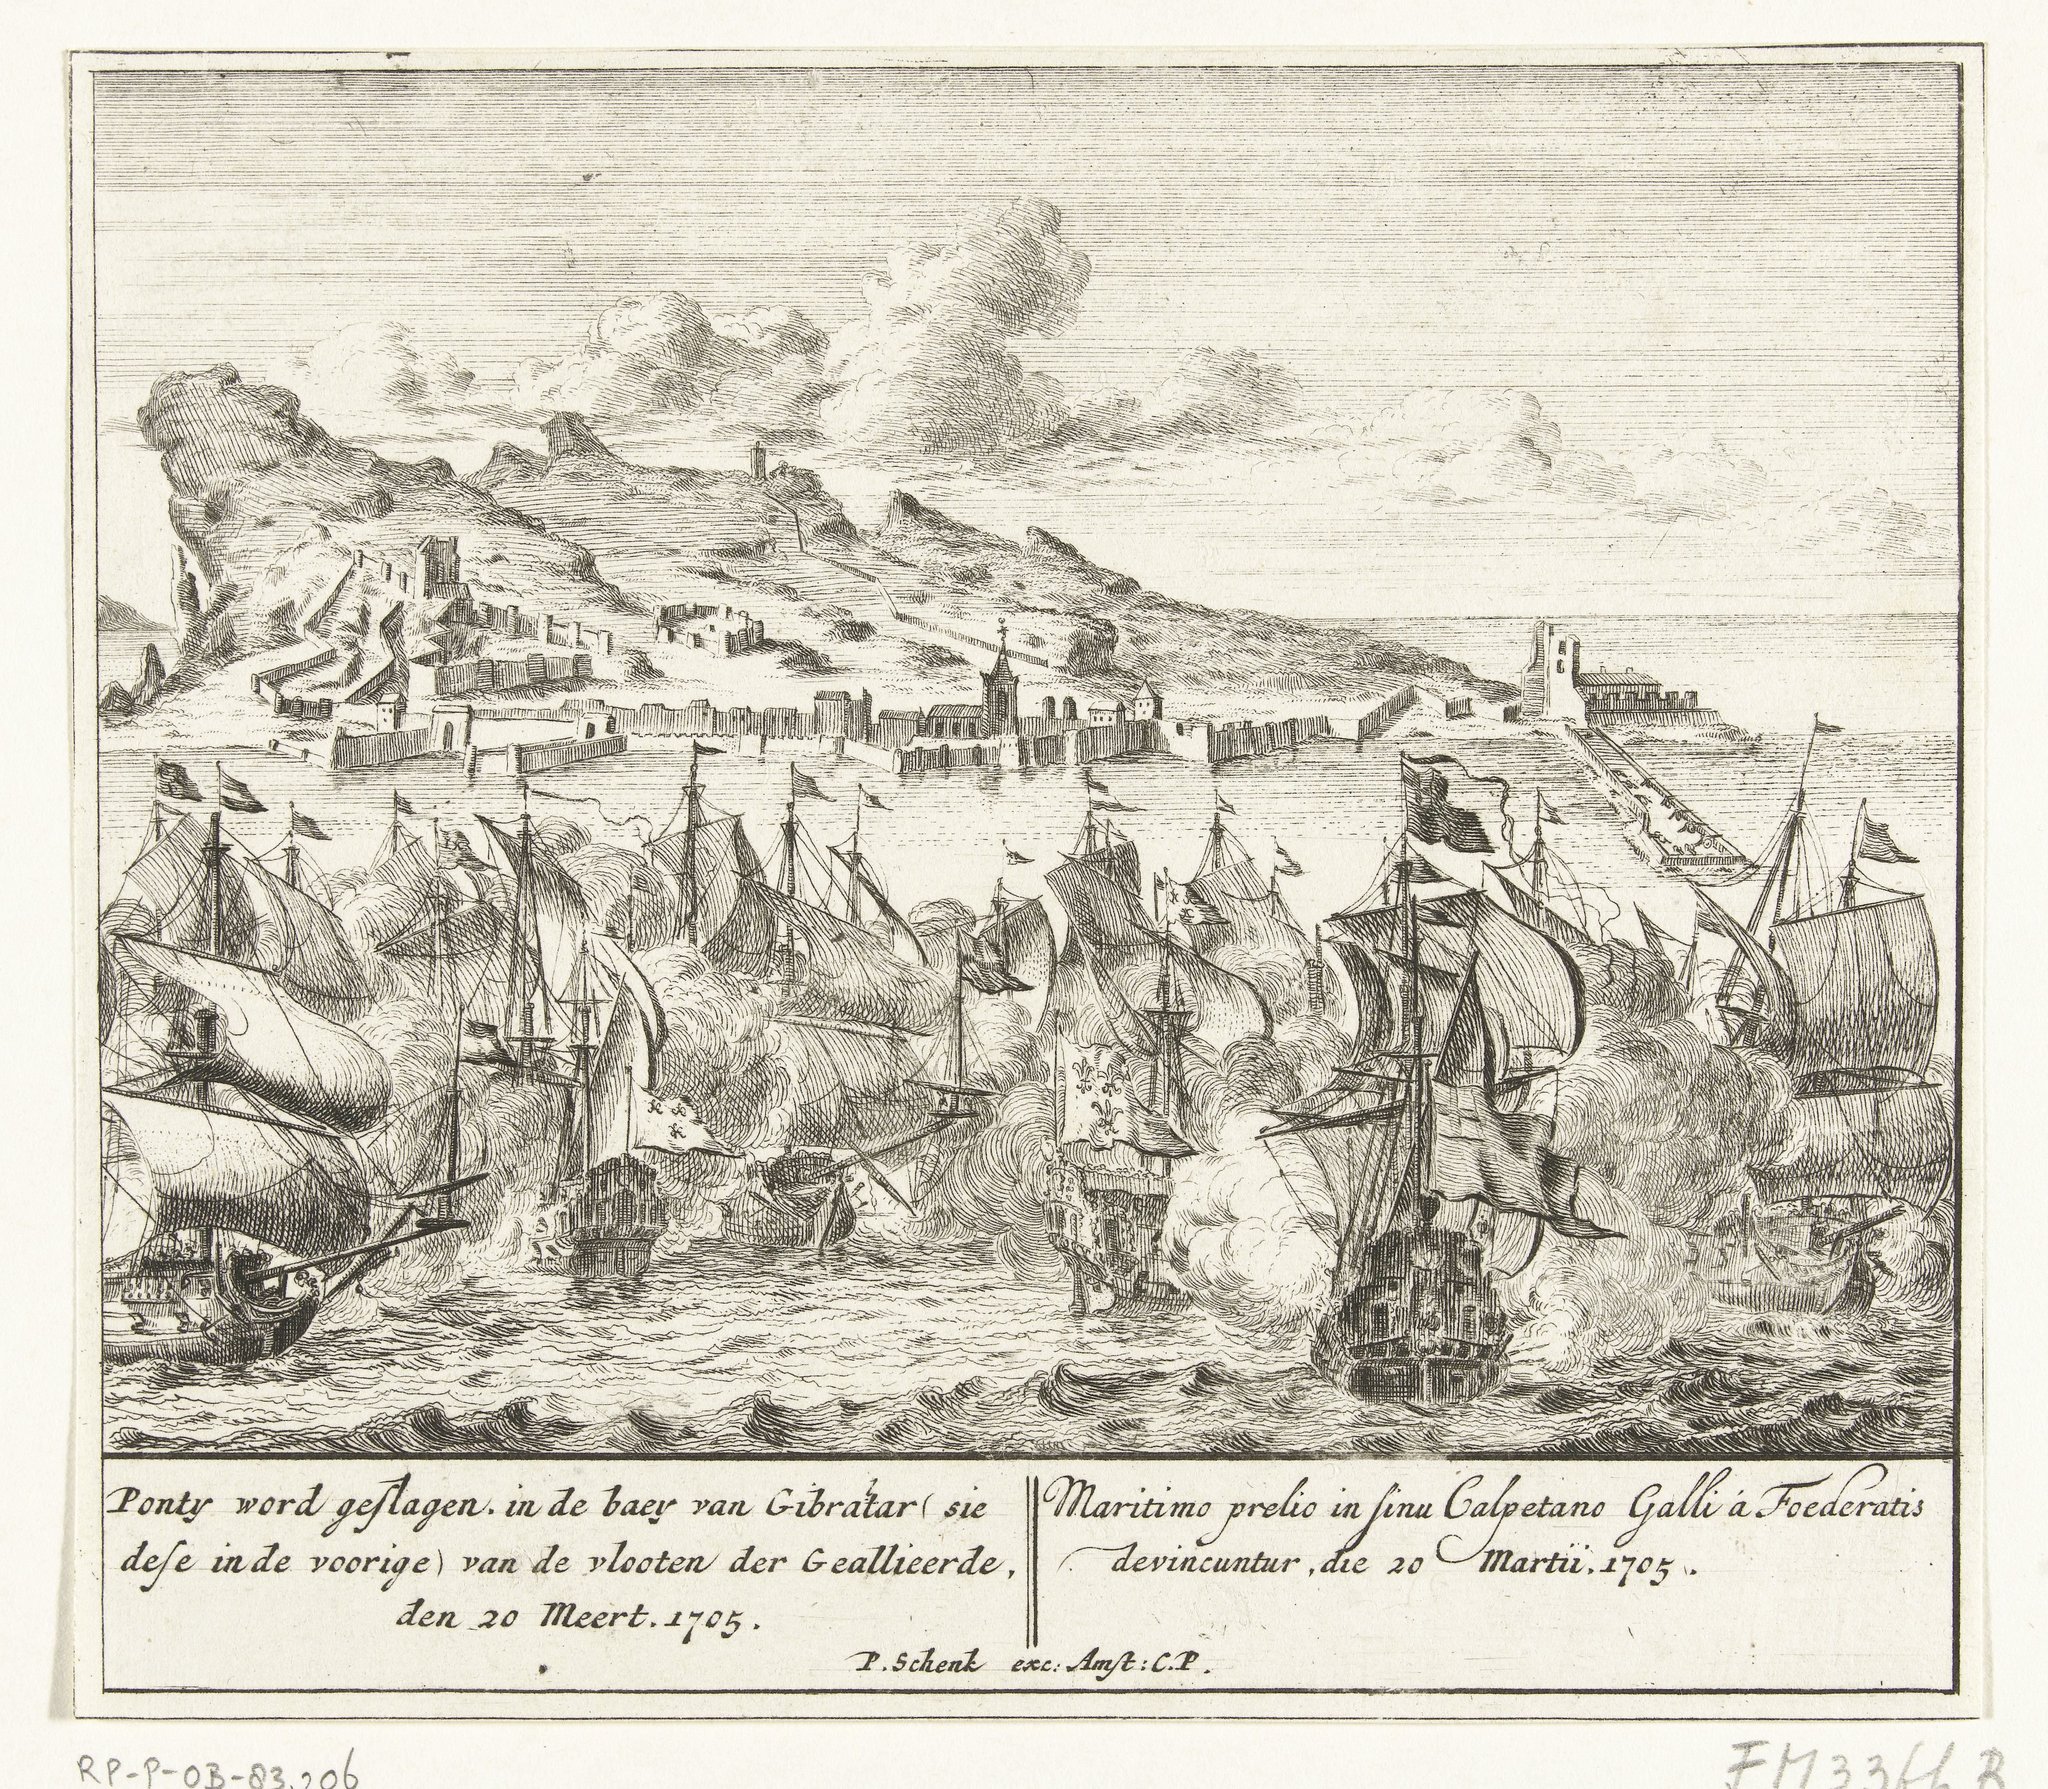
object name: print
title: Ponty word geslagen, in de baey van Gibraltar (sie dese in de voorige) van de vlooten der Geallieerde, den 20 Meert, 1705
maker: pieter schenk (i)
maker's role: print maker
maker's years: 1660-1711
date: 1705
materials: paper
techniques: engraving, etching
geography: amsterdam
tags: battle (+ naval force)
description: Zeeslag bij Gibraltar (Cabrita) waarbij de Engelse vloot een Franse vloot onder admiraal Baron de Pointis versloeg, 21 maart 1705. Ook uitgegeven als een van de negen voorstellingen op een groot blad met gebeurtenissen uit het jaar 1705 van de Spaanse Successieoorlog.